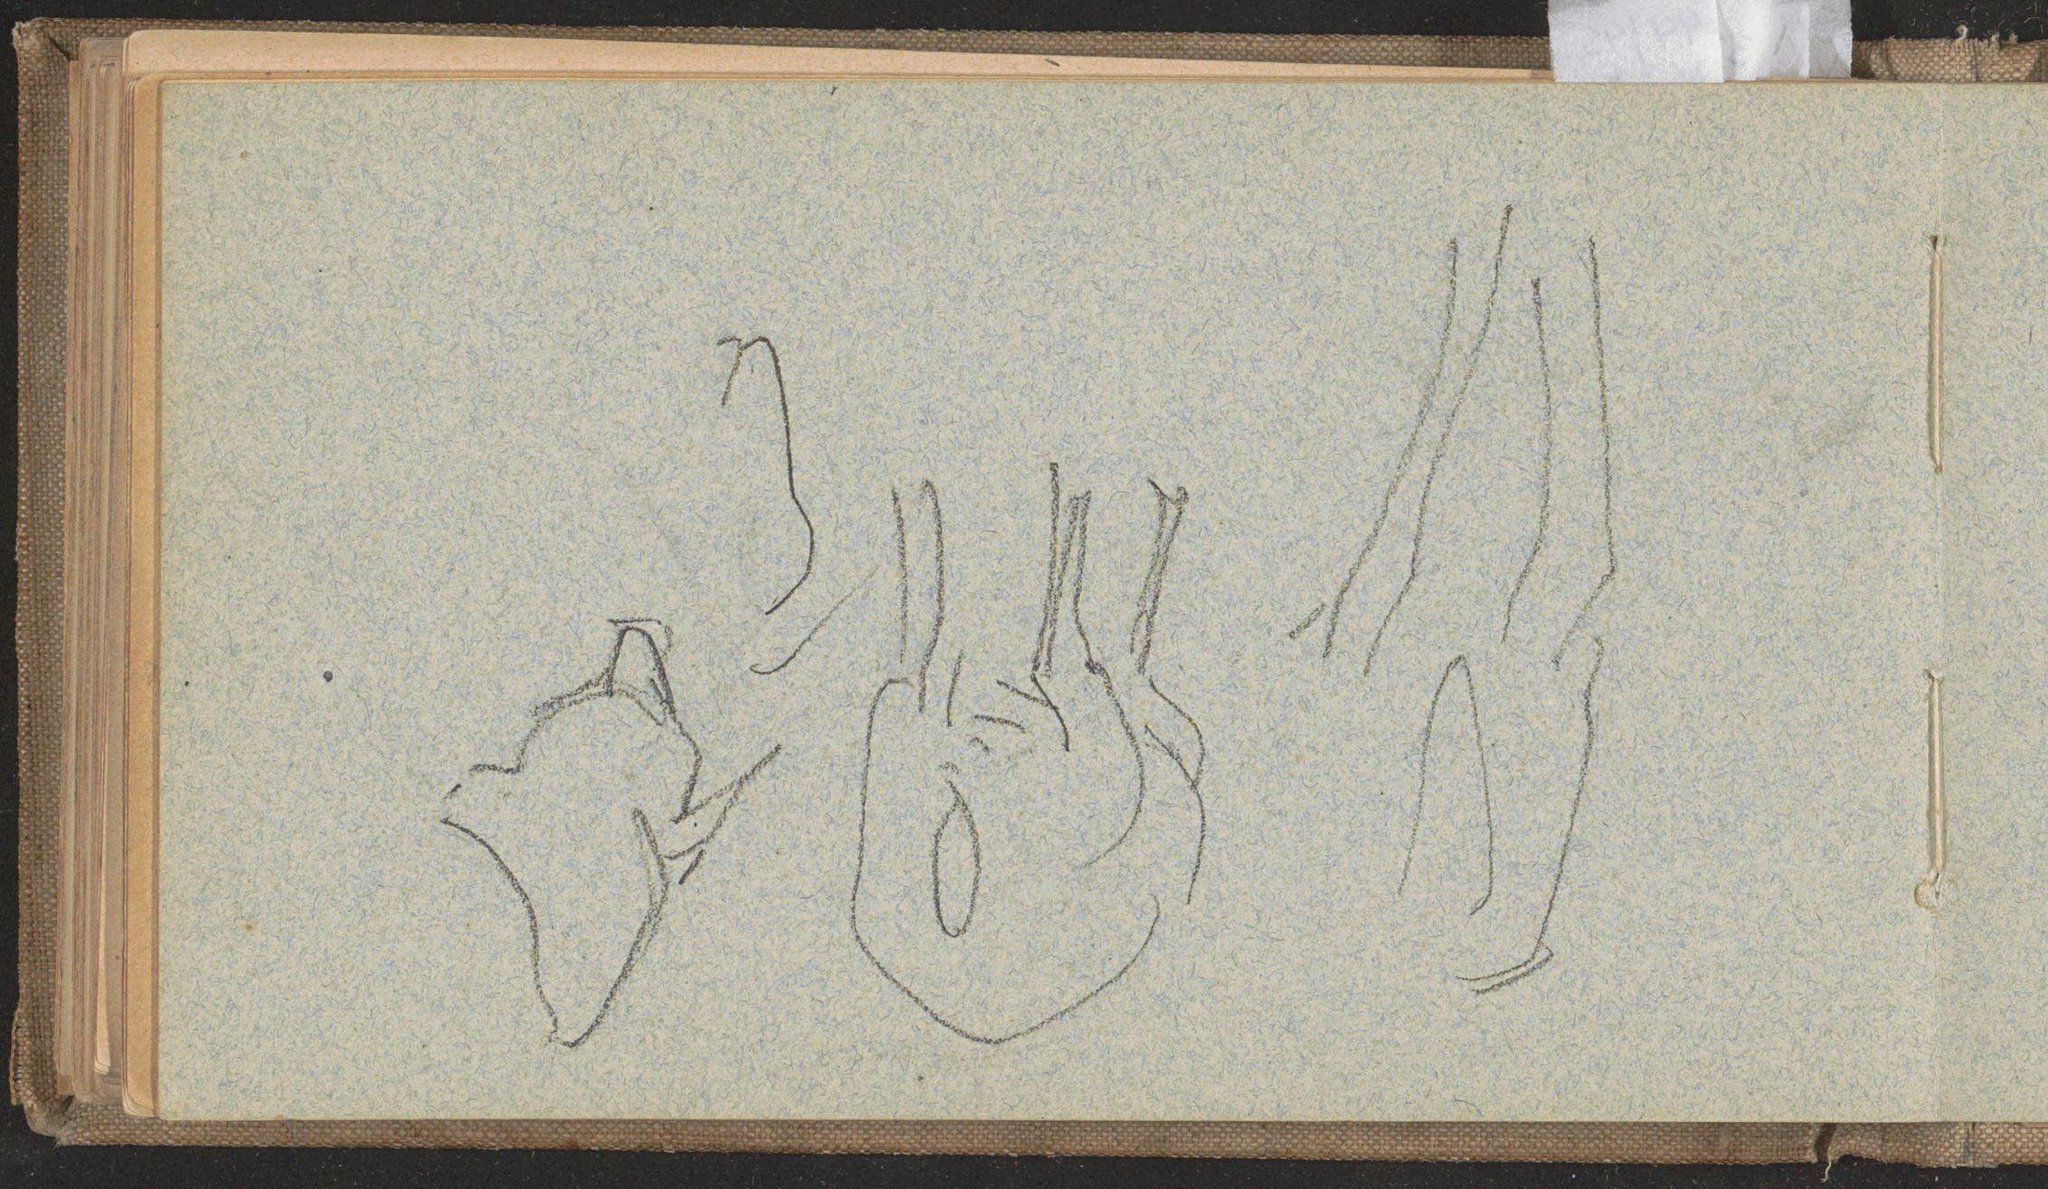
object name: sketchbook leaf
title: Dier, mogelijk een schaap of koe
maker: antoon derkinderen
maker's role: draughtsman, painter, print maker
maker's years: 1859-1925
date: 1892-1901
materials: paper, pencil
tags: animals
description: Blad 45 verso uit een schetsboek met 51 bladen.